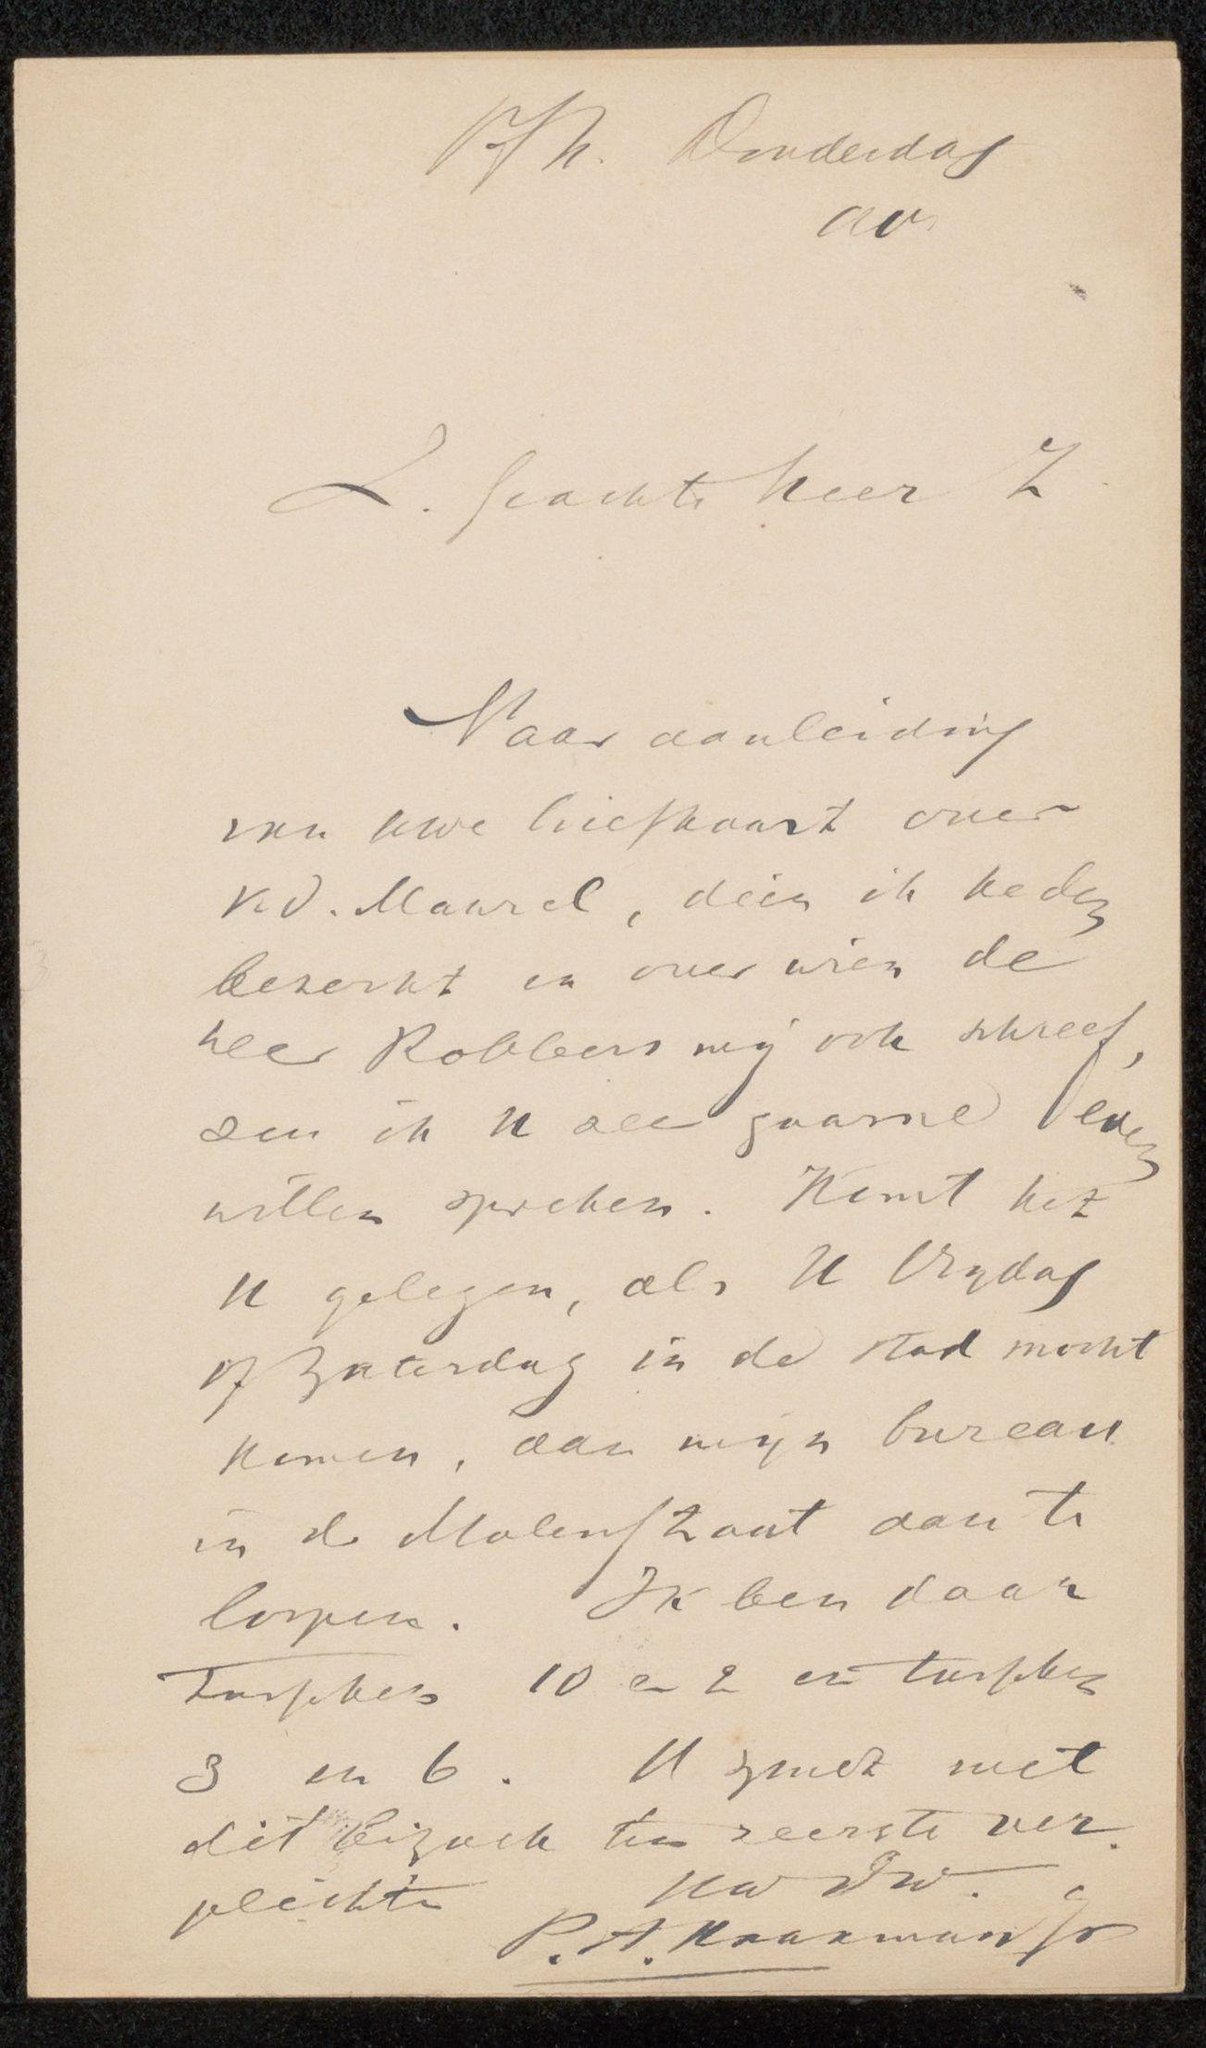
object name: letter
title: Brief aan Philip Zilcken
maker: pieter anne haaxman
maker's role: journalist, kunstcriticus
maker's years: 1847-1935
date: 1867-1930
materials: ink, paper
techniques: pen, writing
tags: the hague, painter, draughtsman, marinus van der maarel, amsterdam, herman robbers, philip zilcken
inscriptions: collector's mark: ‘RPK’